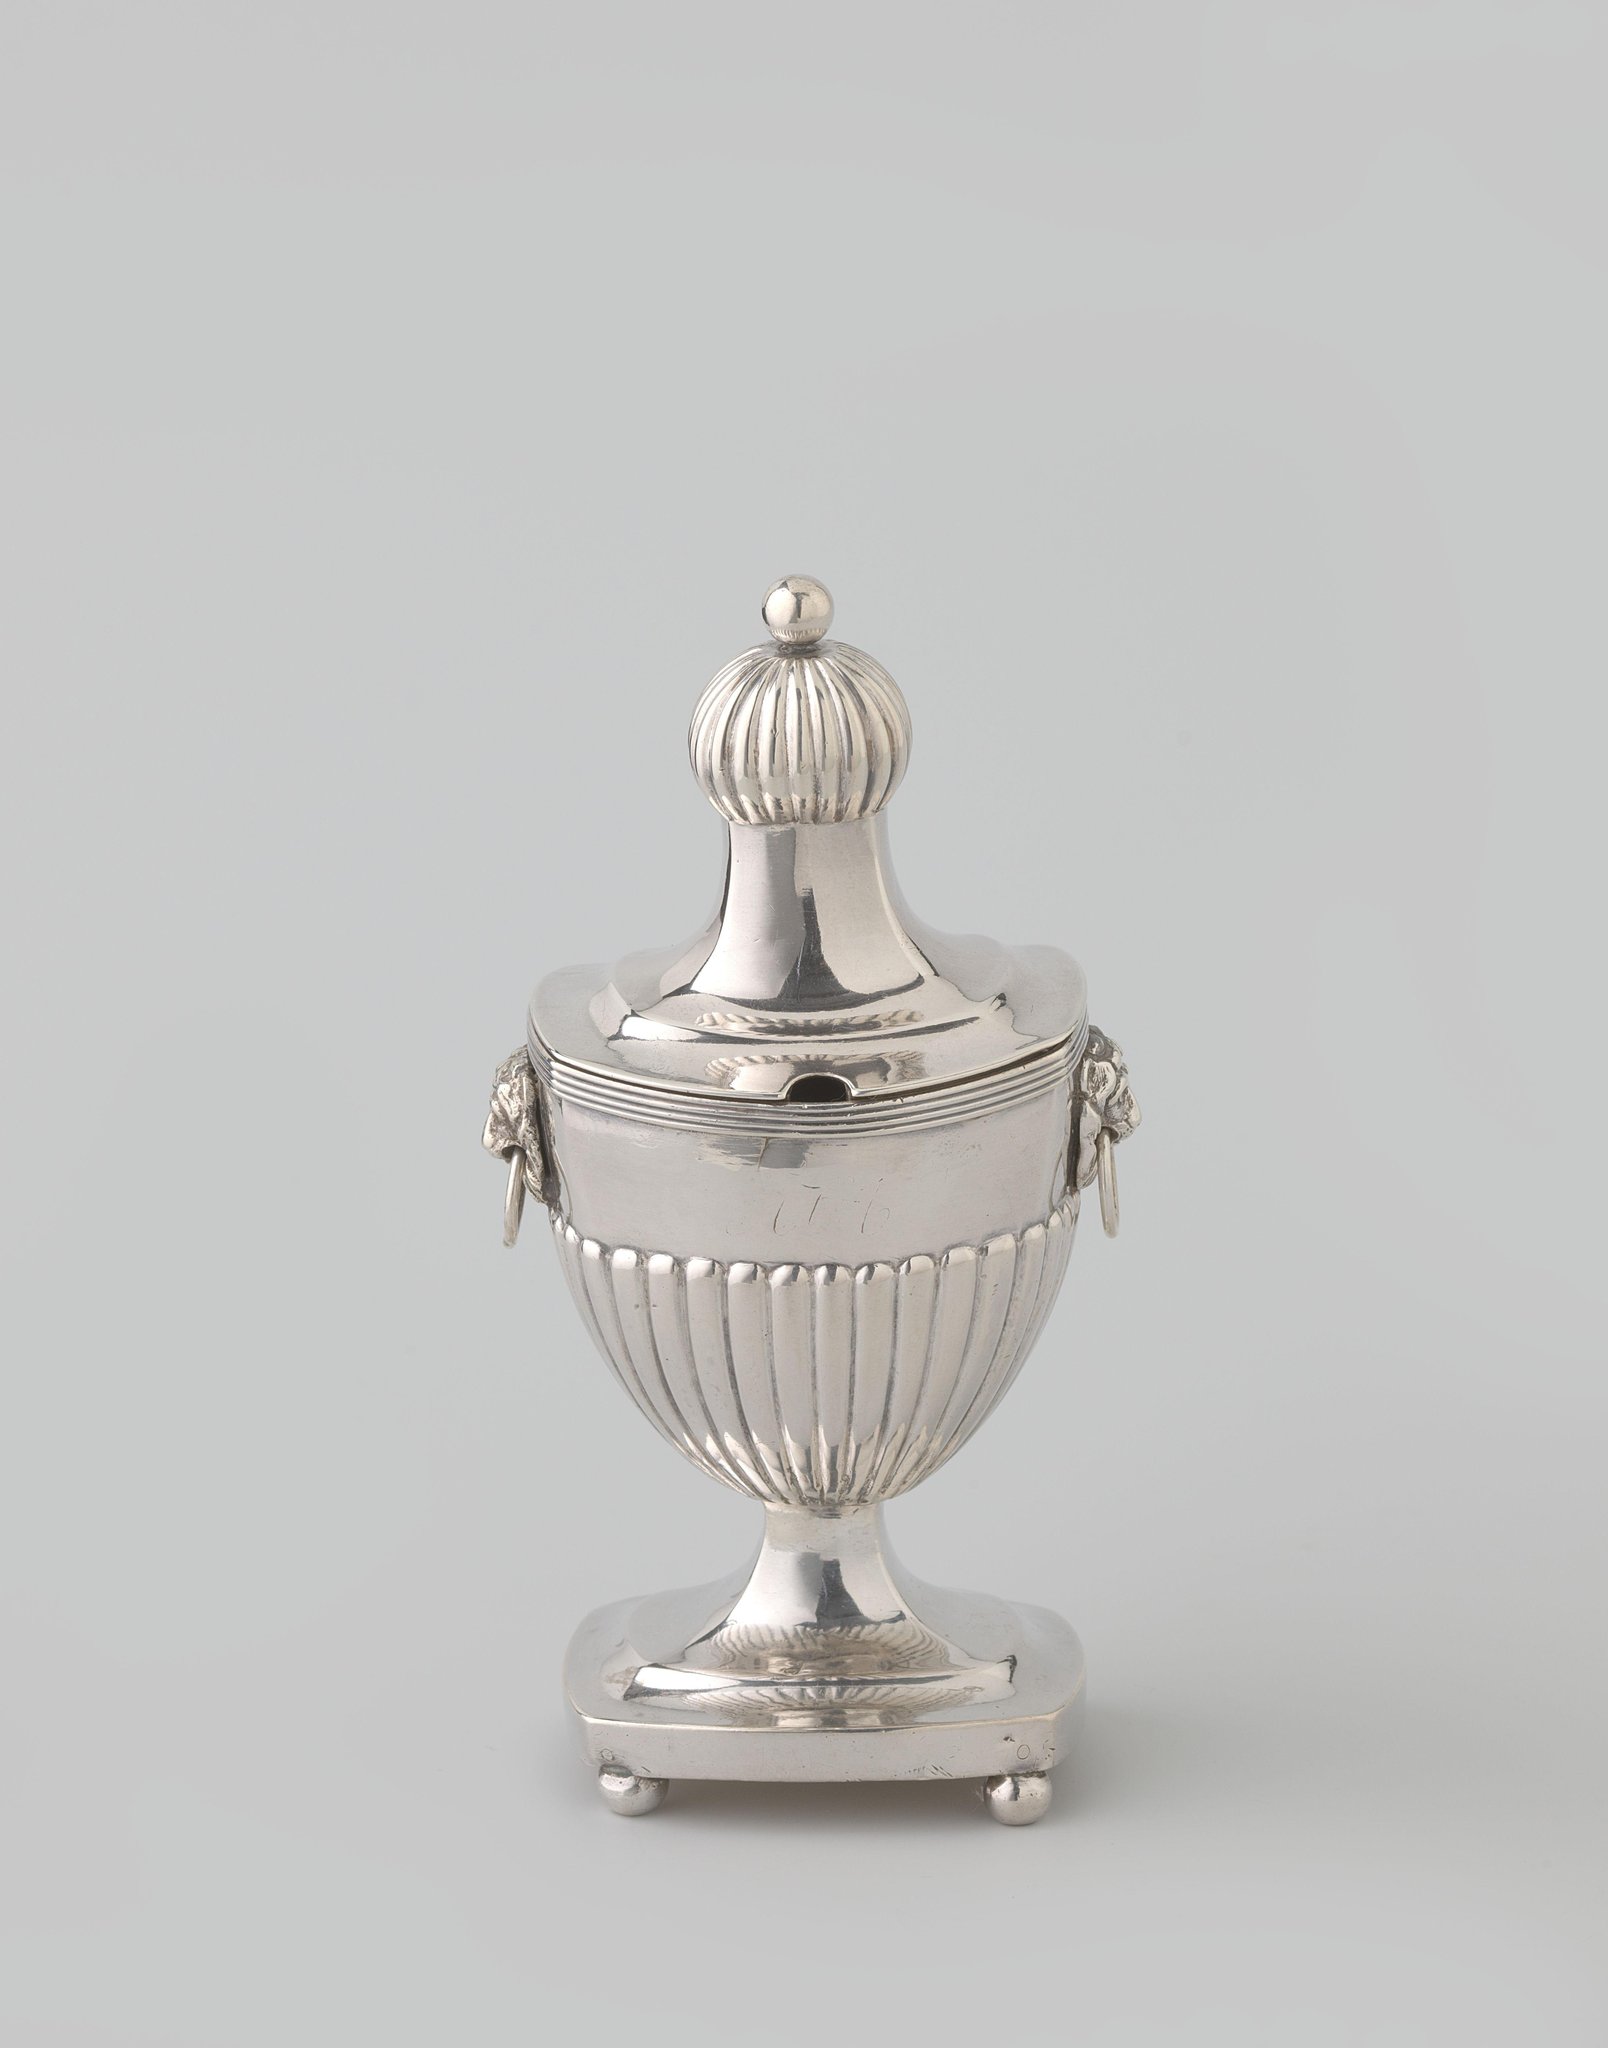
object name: mustard pot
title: Mosterdpot, afgerond rechthoekig, met knerren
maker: jean anthoine de haas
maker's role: silversmith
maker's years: 1753-1835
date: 1826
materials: silver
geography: netherlands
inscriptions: maker's mark, alloy mark, assay office mark, duty mark, date letter: ‘R’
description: De twee afgerond rechthoekige potten (A en B) rusten op een voet, die is opgebouwd uit twee gewelfde, zich verjongende gedeeltes boven een rechtwandige basis, staande op vier bolvormige pootjes. Het lichaam loopt aan de zijkanten hoger op. Het dubbel gewelfde, zich verjongende deksel wordt bekroond door een bol, geribd gedeelte dat bij de peperbus opengewerkt is. Op het deksel bevindt zich een bol knopje Op het lichaam zijn tot op ongeveer tweederde van de hoogte knerren aangebracht. Langs de boven-rand loopt een filetrand. Hieronder bevinden zich twee oren in de vorm van leeuwenmaskers met ringen door de bek. De peperbus heeft een los deksel, terwijl dat van de mosterdpot scharnierend is en een kleine halfronde opening heeft waarin een lepeltje gestoken kan worden. Het deksel van de mosterdpot is aan de binnenzijde verguld.